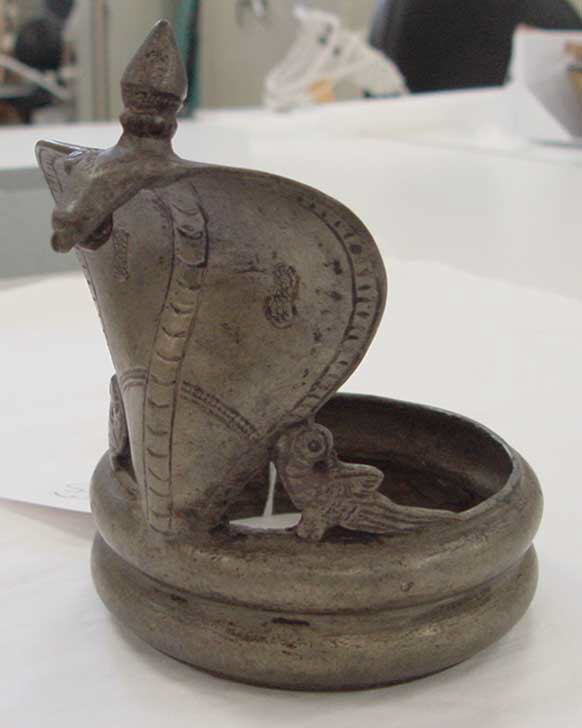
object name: bracelet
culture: indian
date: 1801-1900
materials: metal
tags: birds,snakes